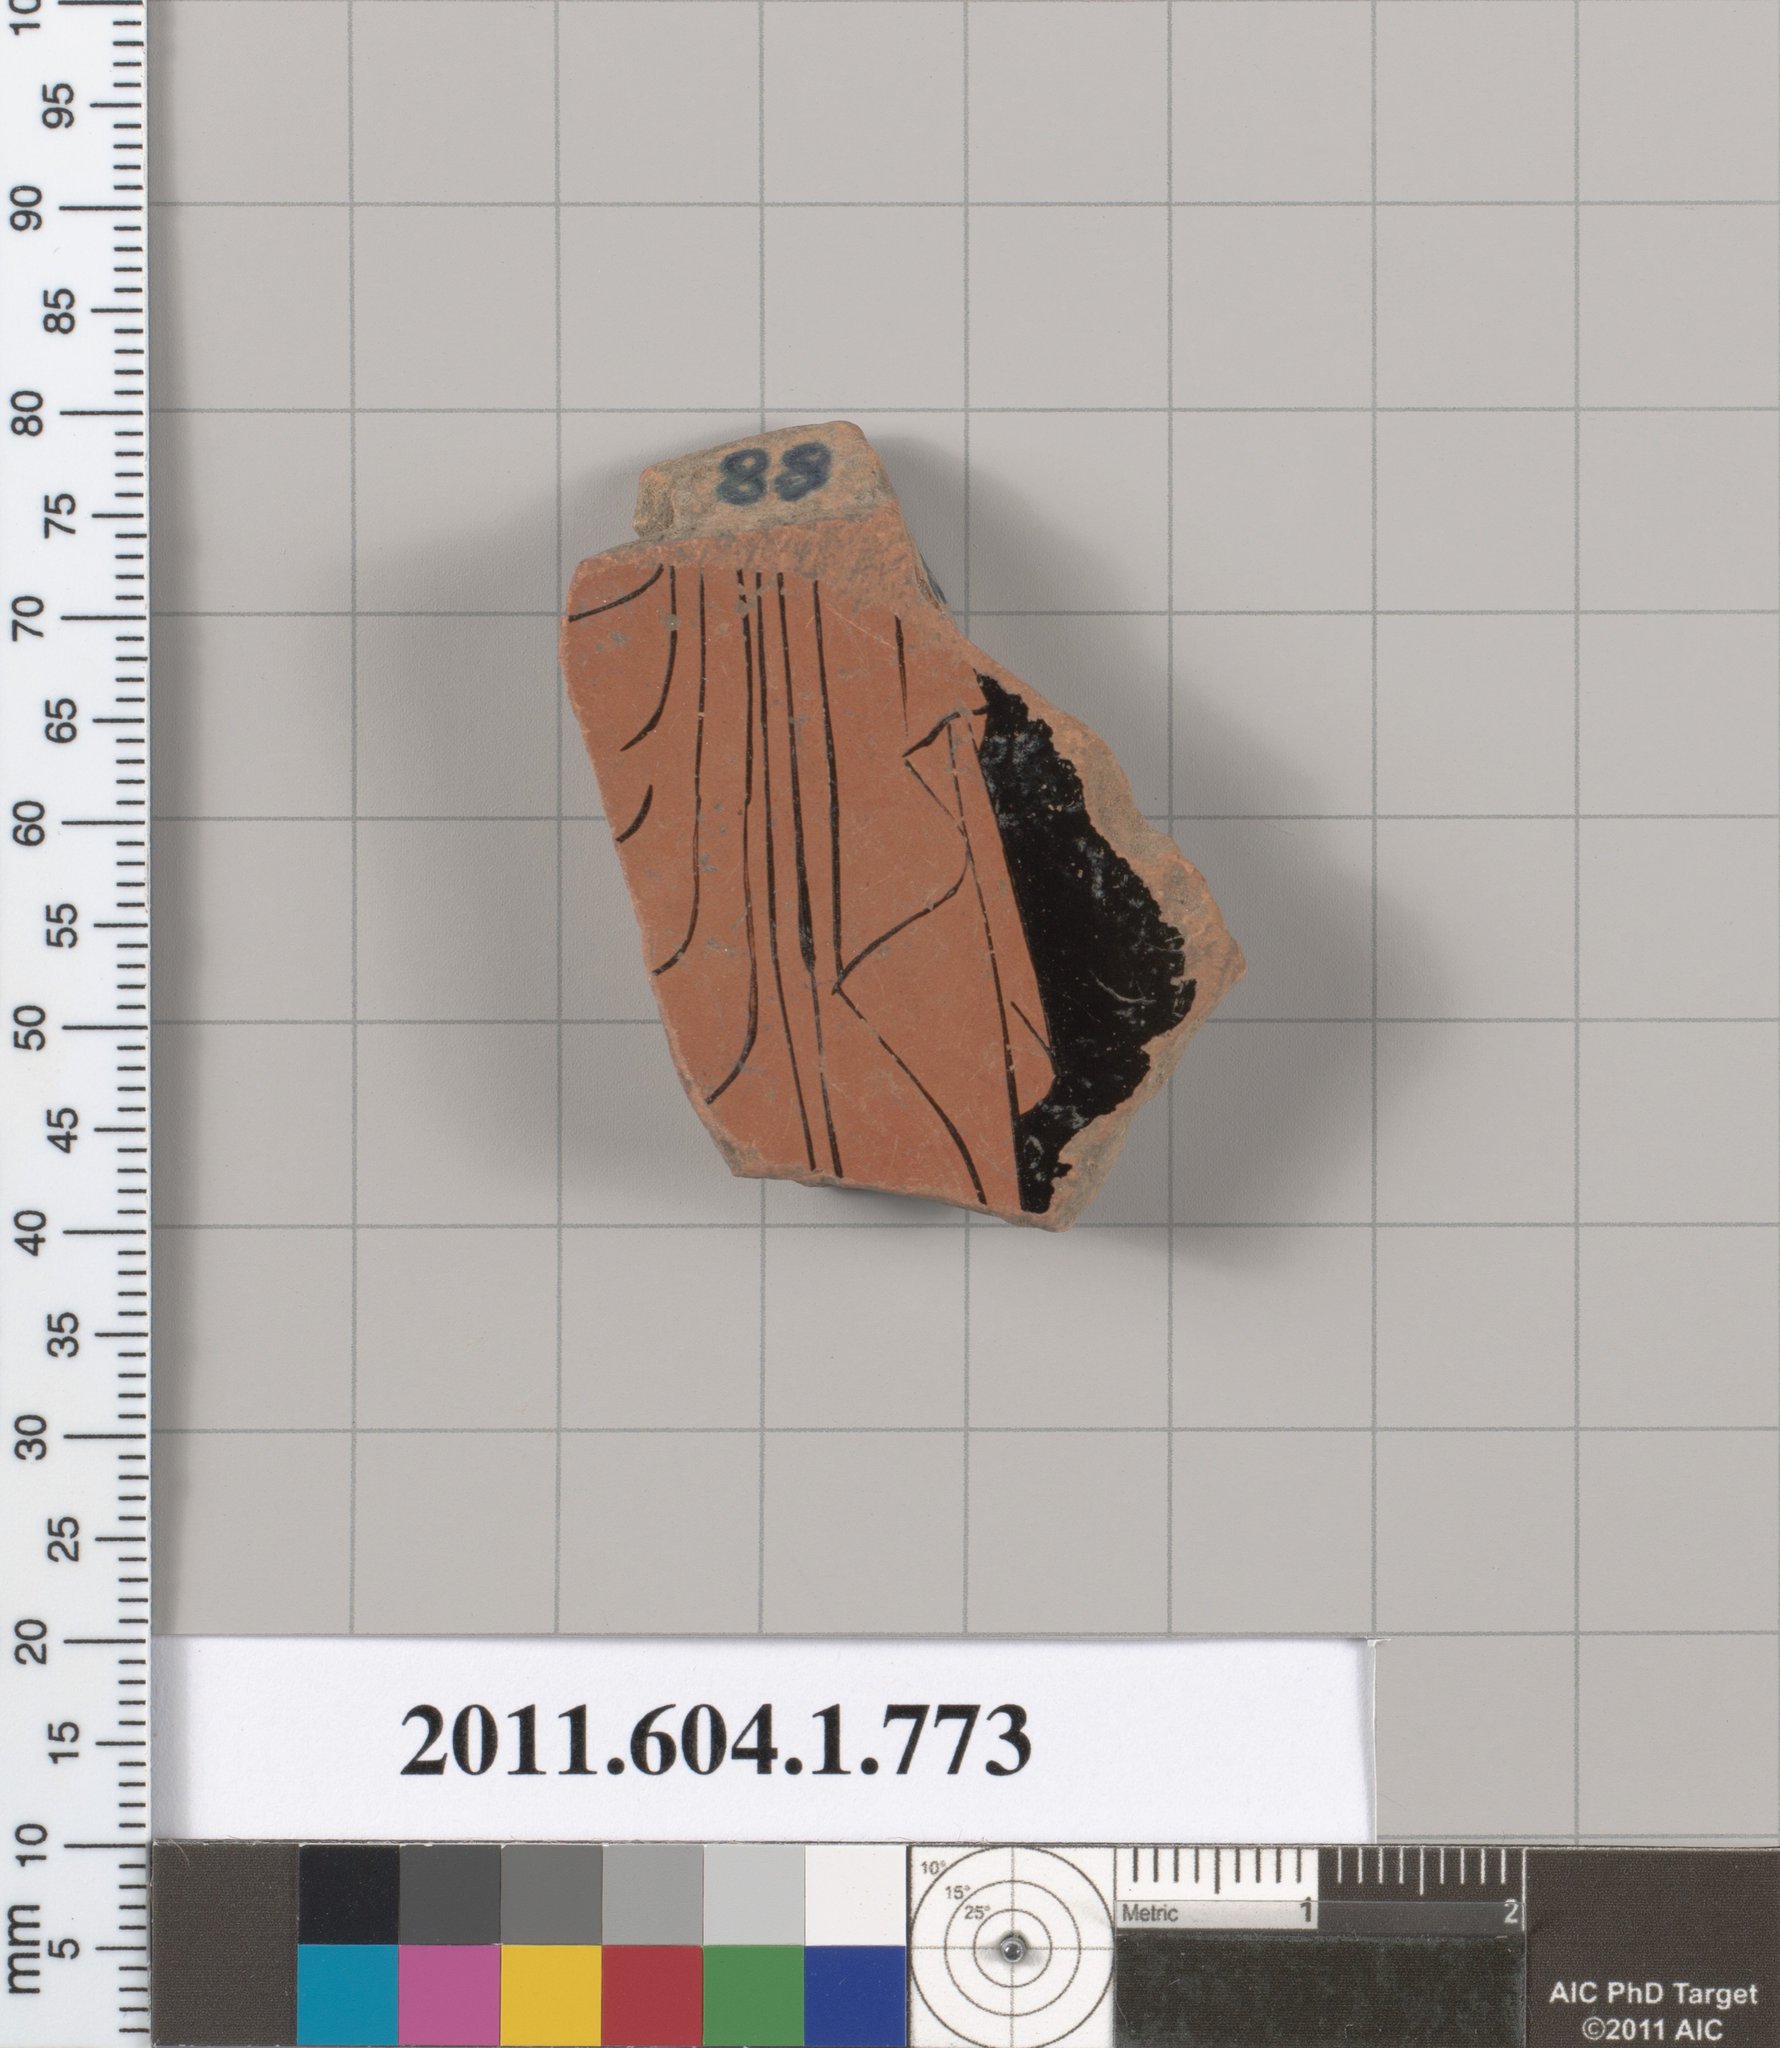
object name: kylix fragment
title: Terracotta fragment of a kylix (drinking cup)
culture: greek, attic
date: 475-451 BCE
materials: terracotta